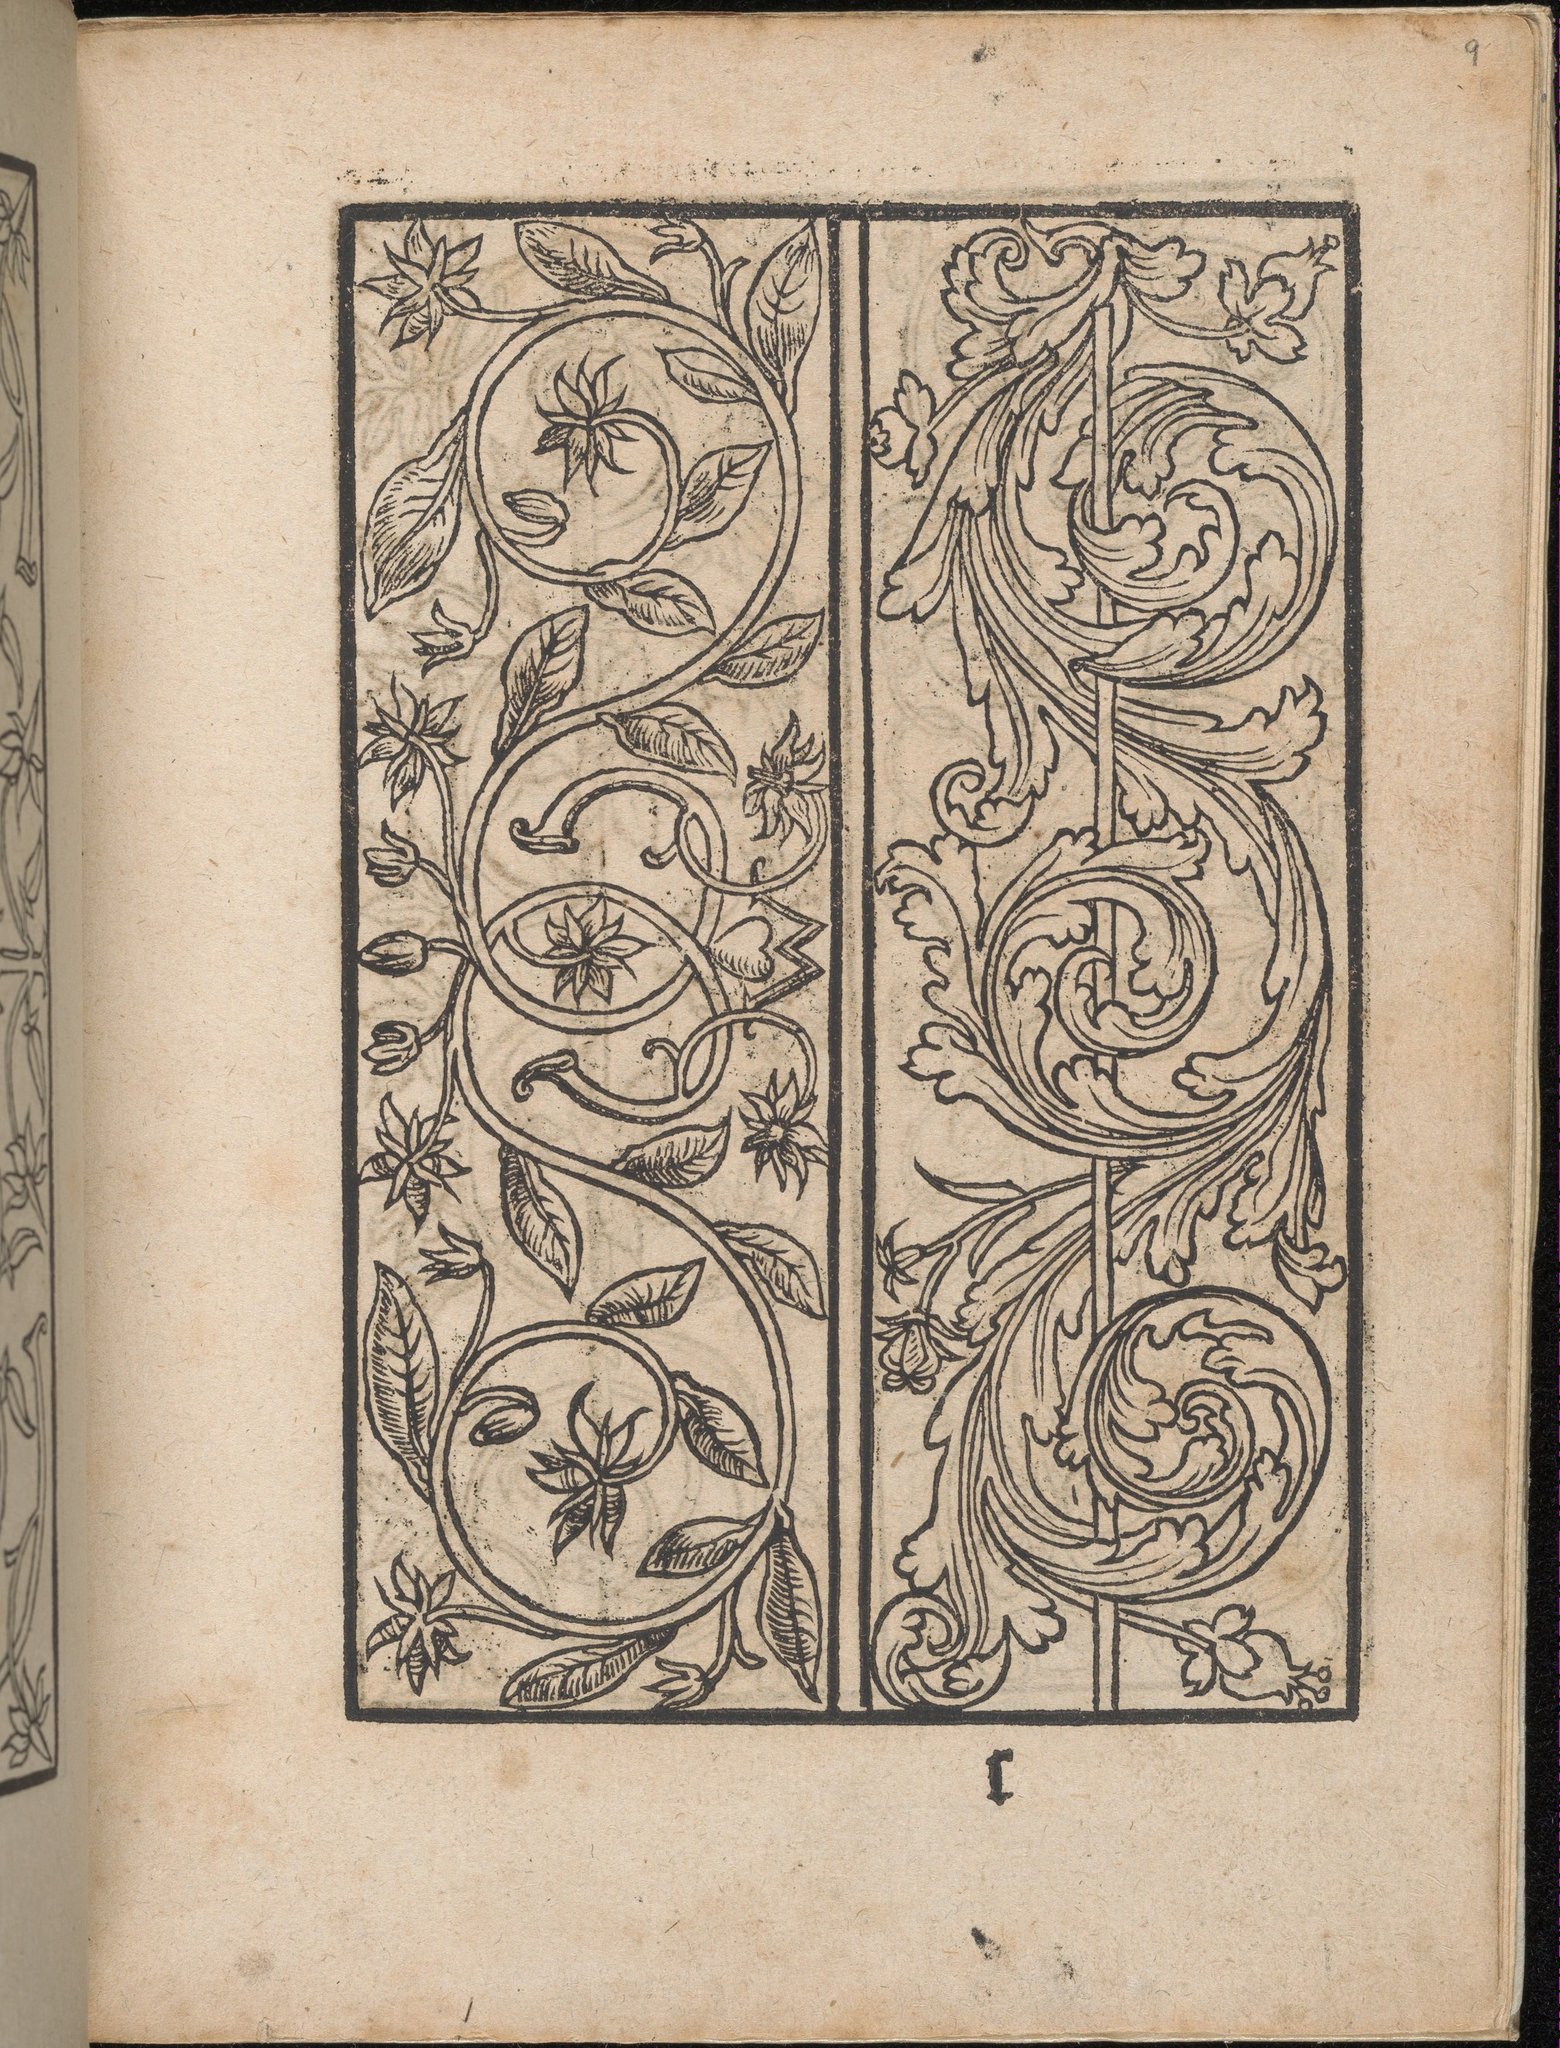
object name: book print ornament architecture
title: Ein new Modelbuch..., page 5 (recto)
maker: johann schönsperger the younger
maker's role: publisher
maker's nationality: german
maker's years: 1490-1550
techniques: woodcut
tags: acorns